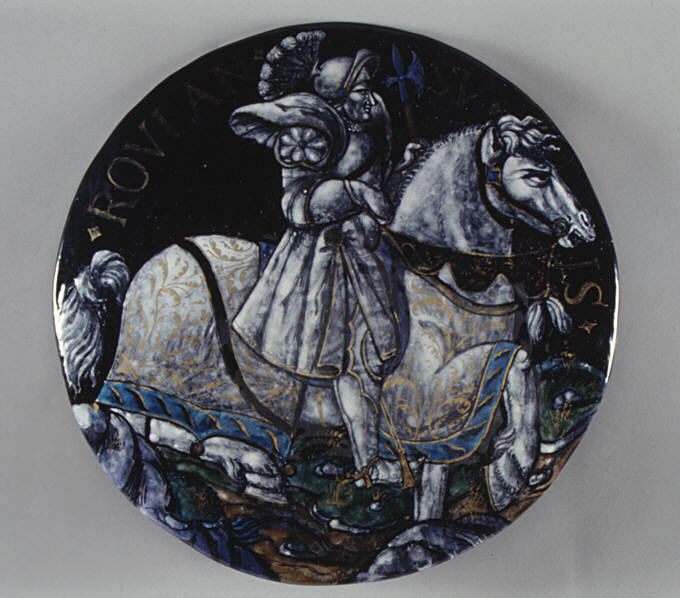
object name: medallion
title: Roland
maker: colin nouailher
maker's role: enameler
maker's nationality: french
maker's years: 1471-1571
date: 1541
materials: copper, enamel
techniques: gilding, painting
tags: men,horses